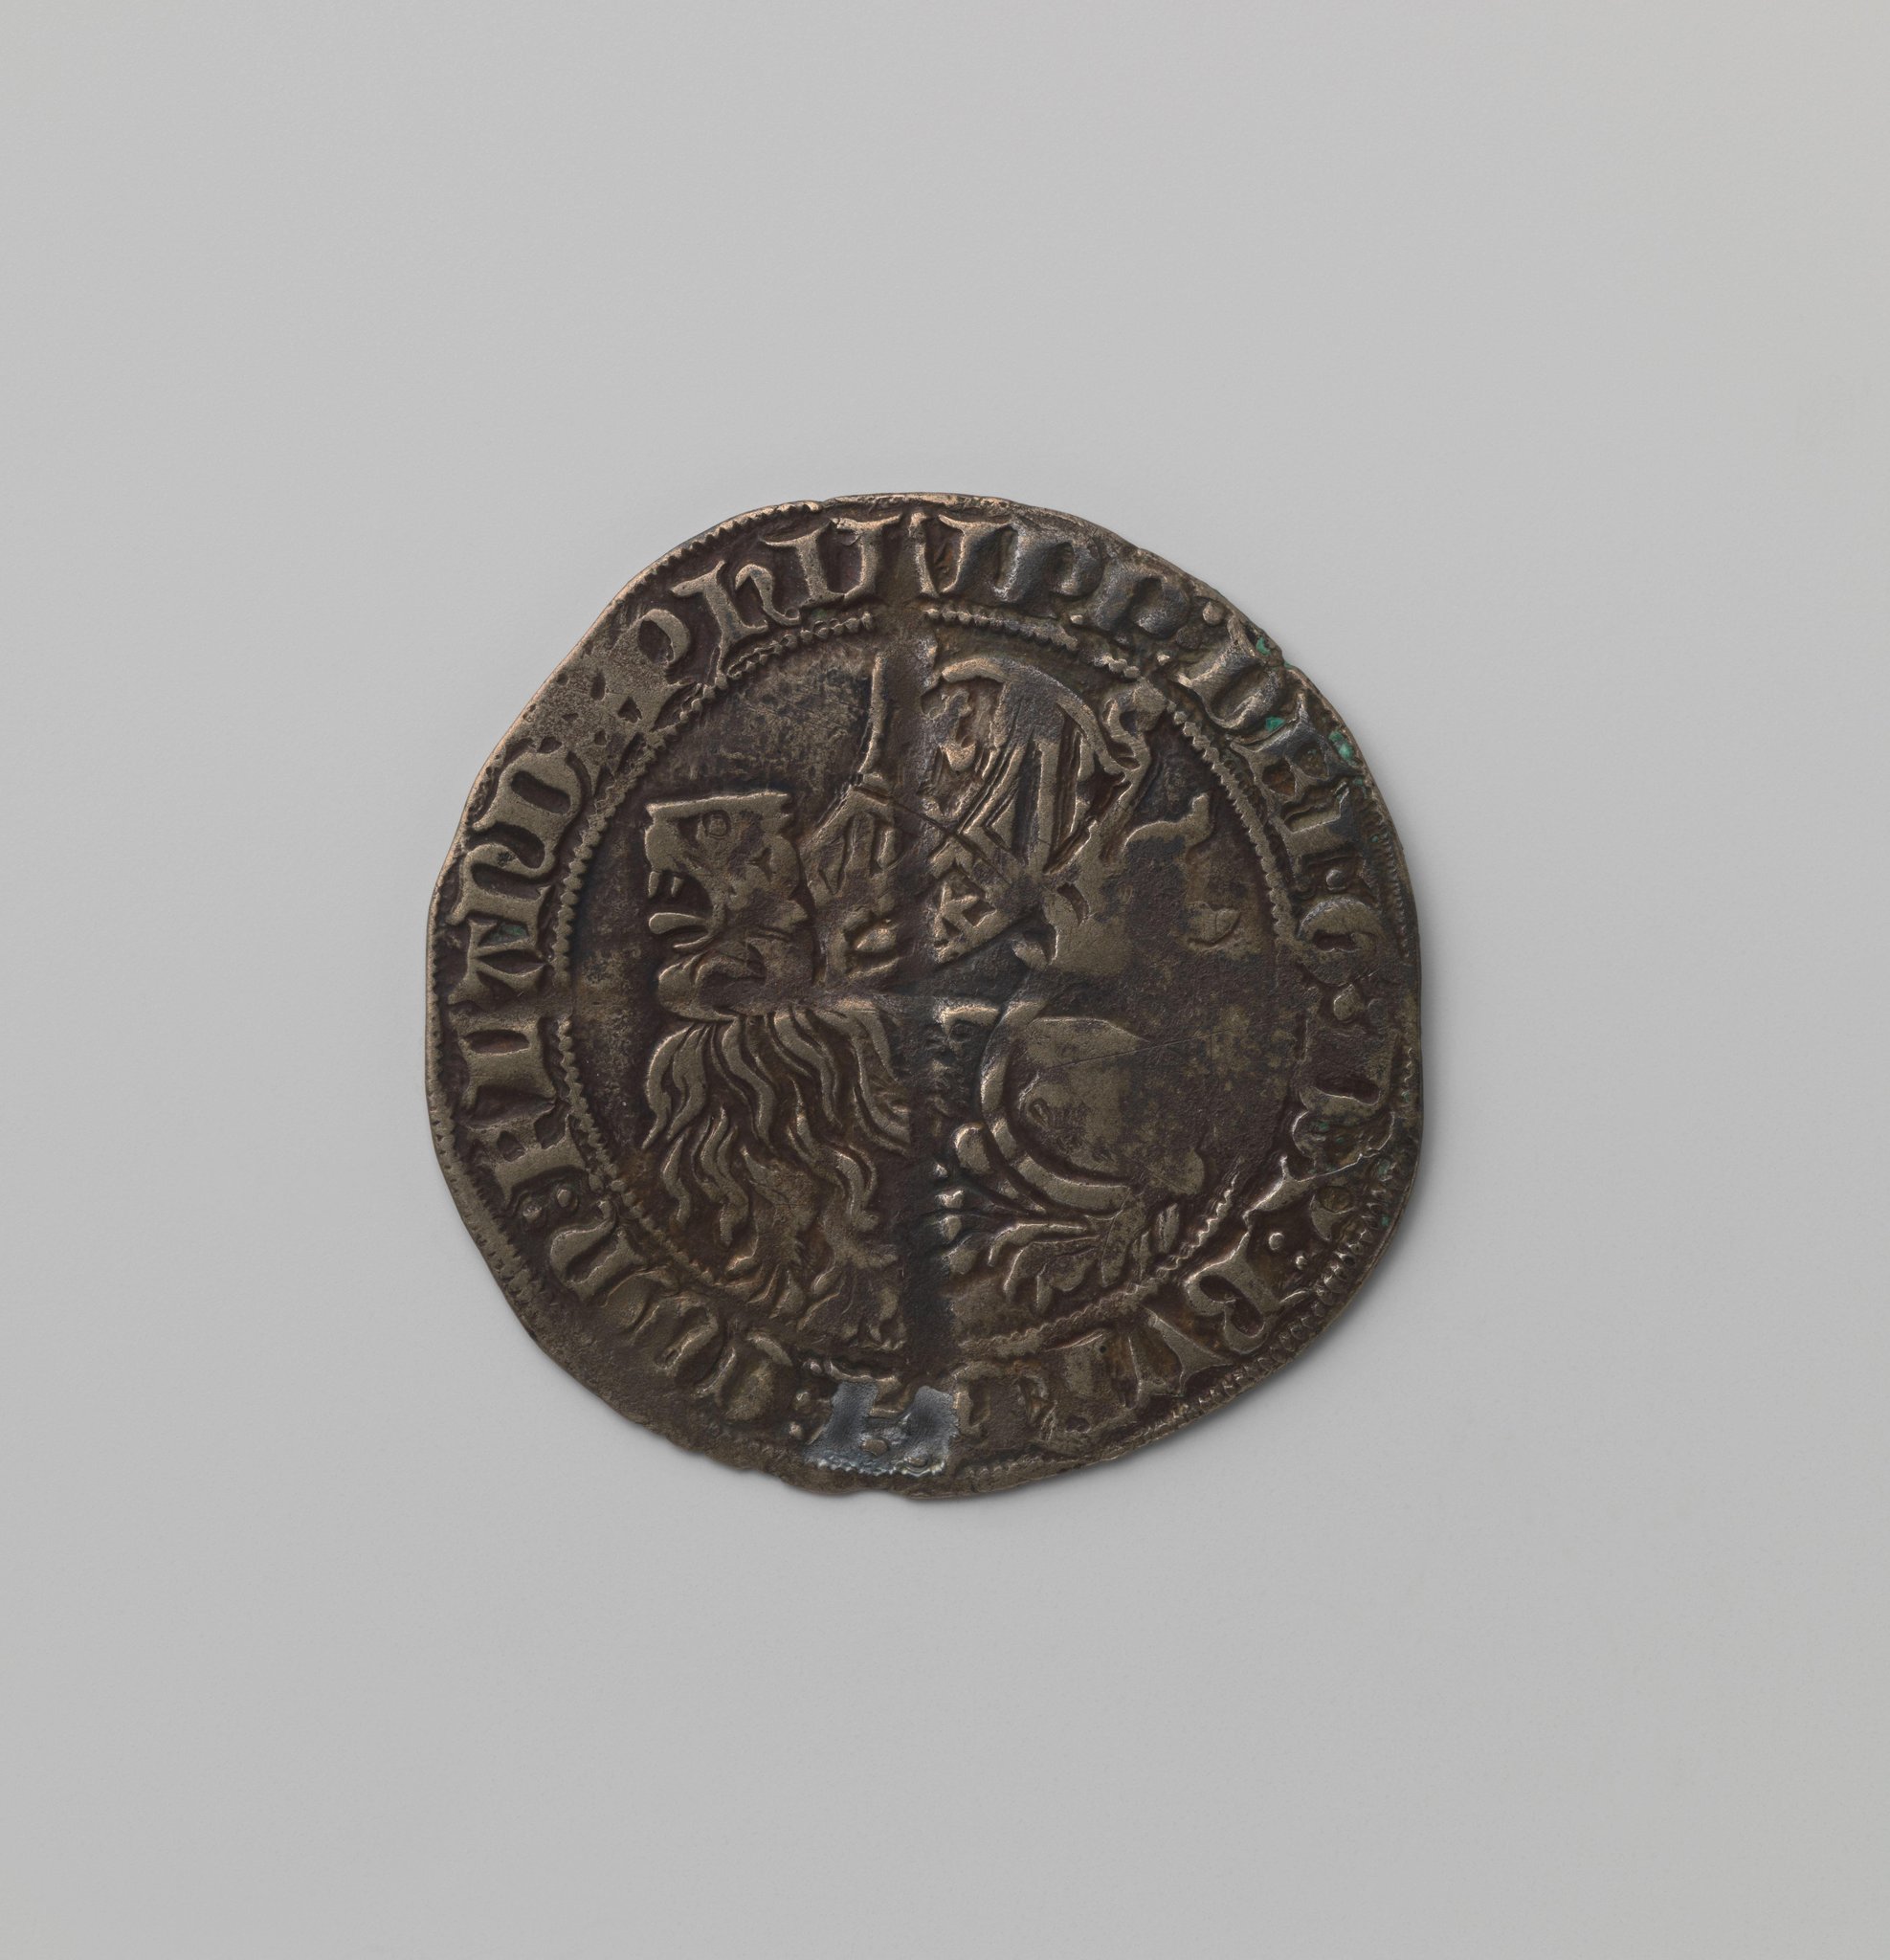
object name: coin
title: Vlaanderen, Philips de Stoute, dubbele groot botdrager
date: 1384-1404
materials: silver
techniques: striking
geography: ghent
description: Voorzijde: gaande leeuw naar links, op de rug wapenschild in de vorm van een mand [bodde]. Keerzijde: wapenschild op lang gevoet kruis.